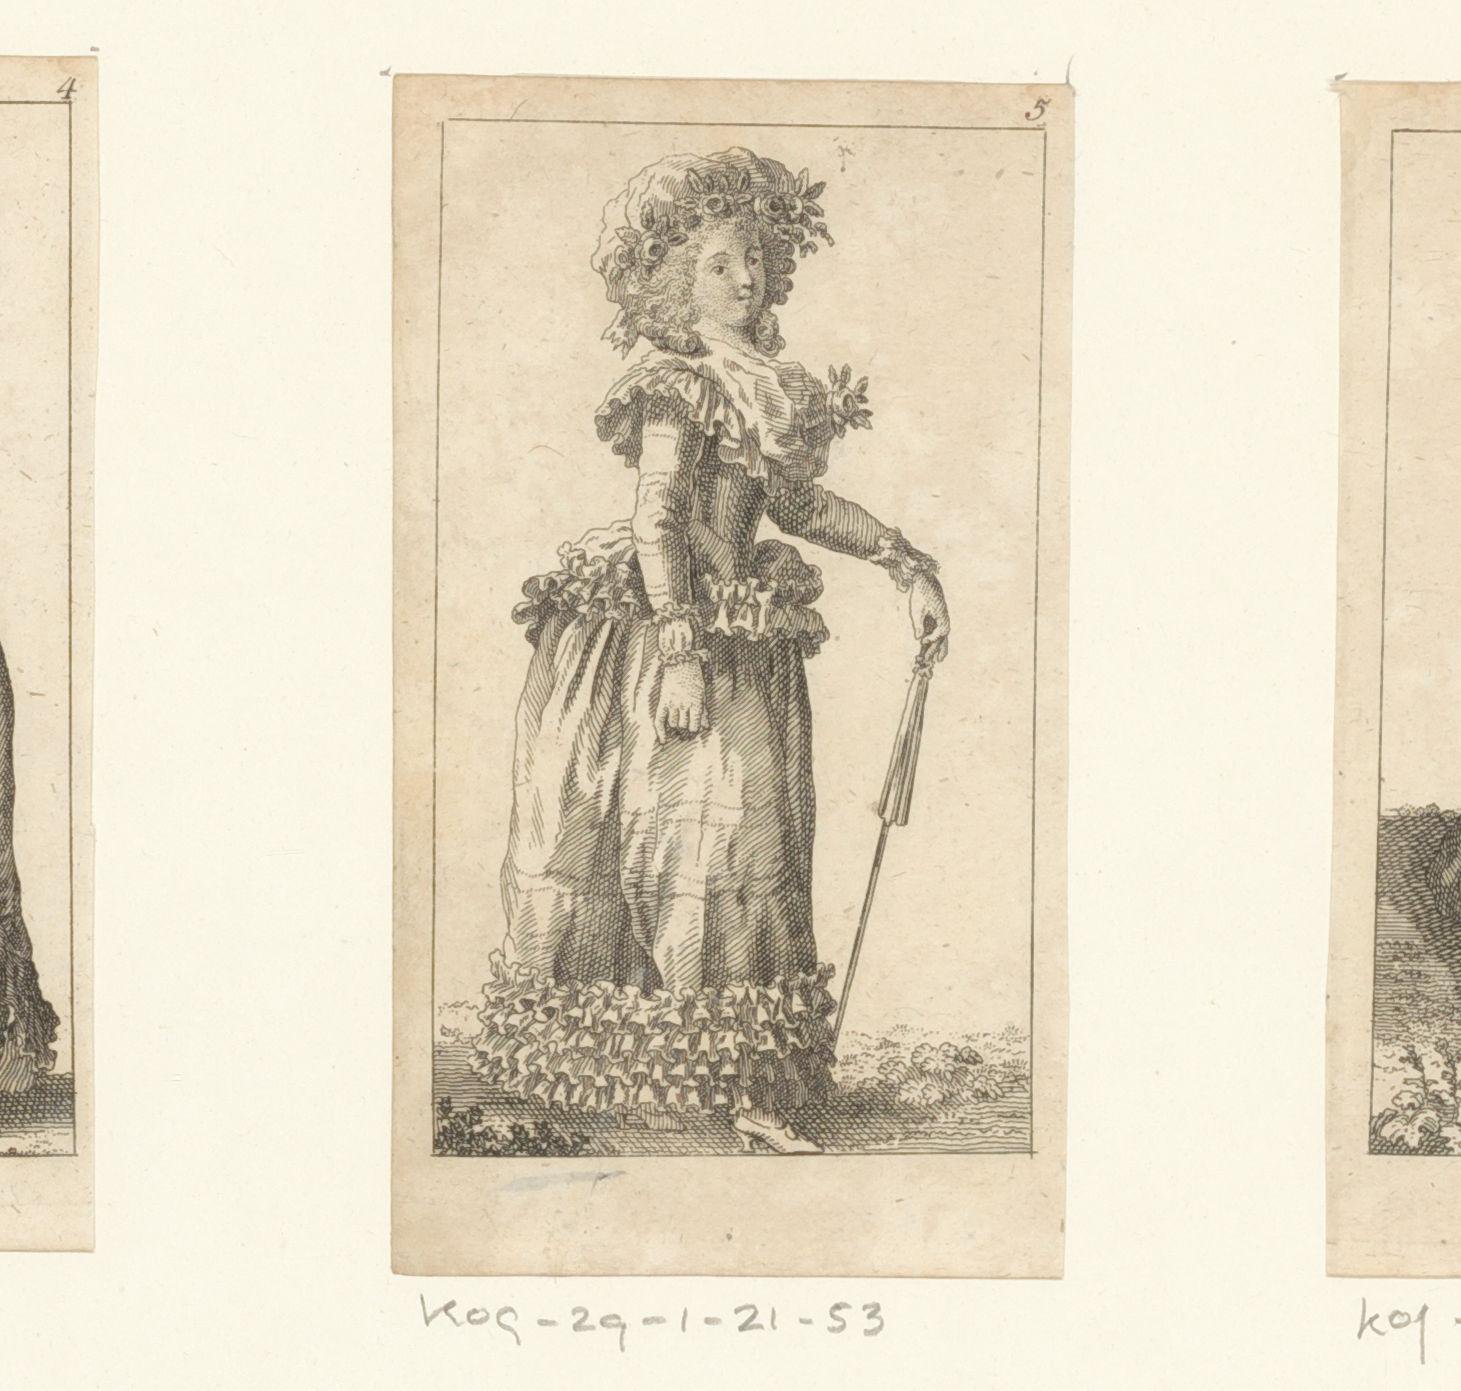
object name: print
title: Staande vrouw met parasol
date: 1780-1840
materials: paper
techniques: etching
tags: head-gear: hat, dress, gown, parasol, sunshade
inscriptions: collector's mark: Lugt 1641, stamp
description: Rechtsboven genummerd: 5. Onderwerpsrubrieken binnen de Atlas Zeden en Gewoonten: Zeden en Gewoonten in Engeren Zin, De Kleeding, Kleederdrachten (tijdvakken), De 18de eeuw (de pruikentijd). Mannen en vrouwen.